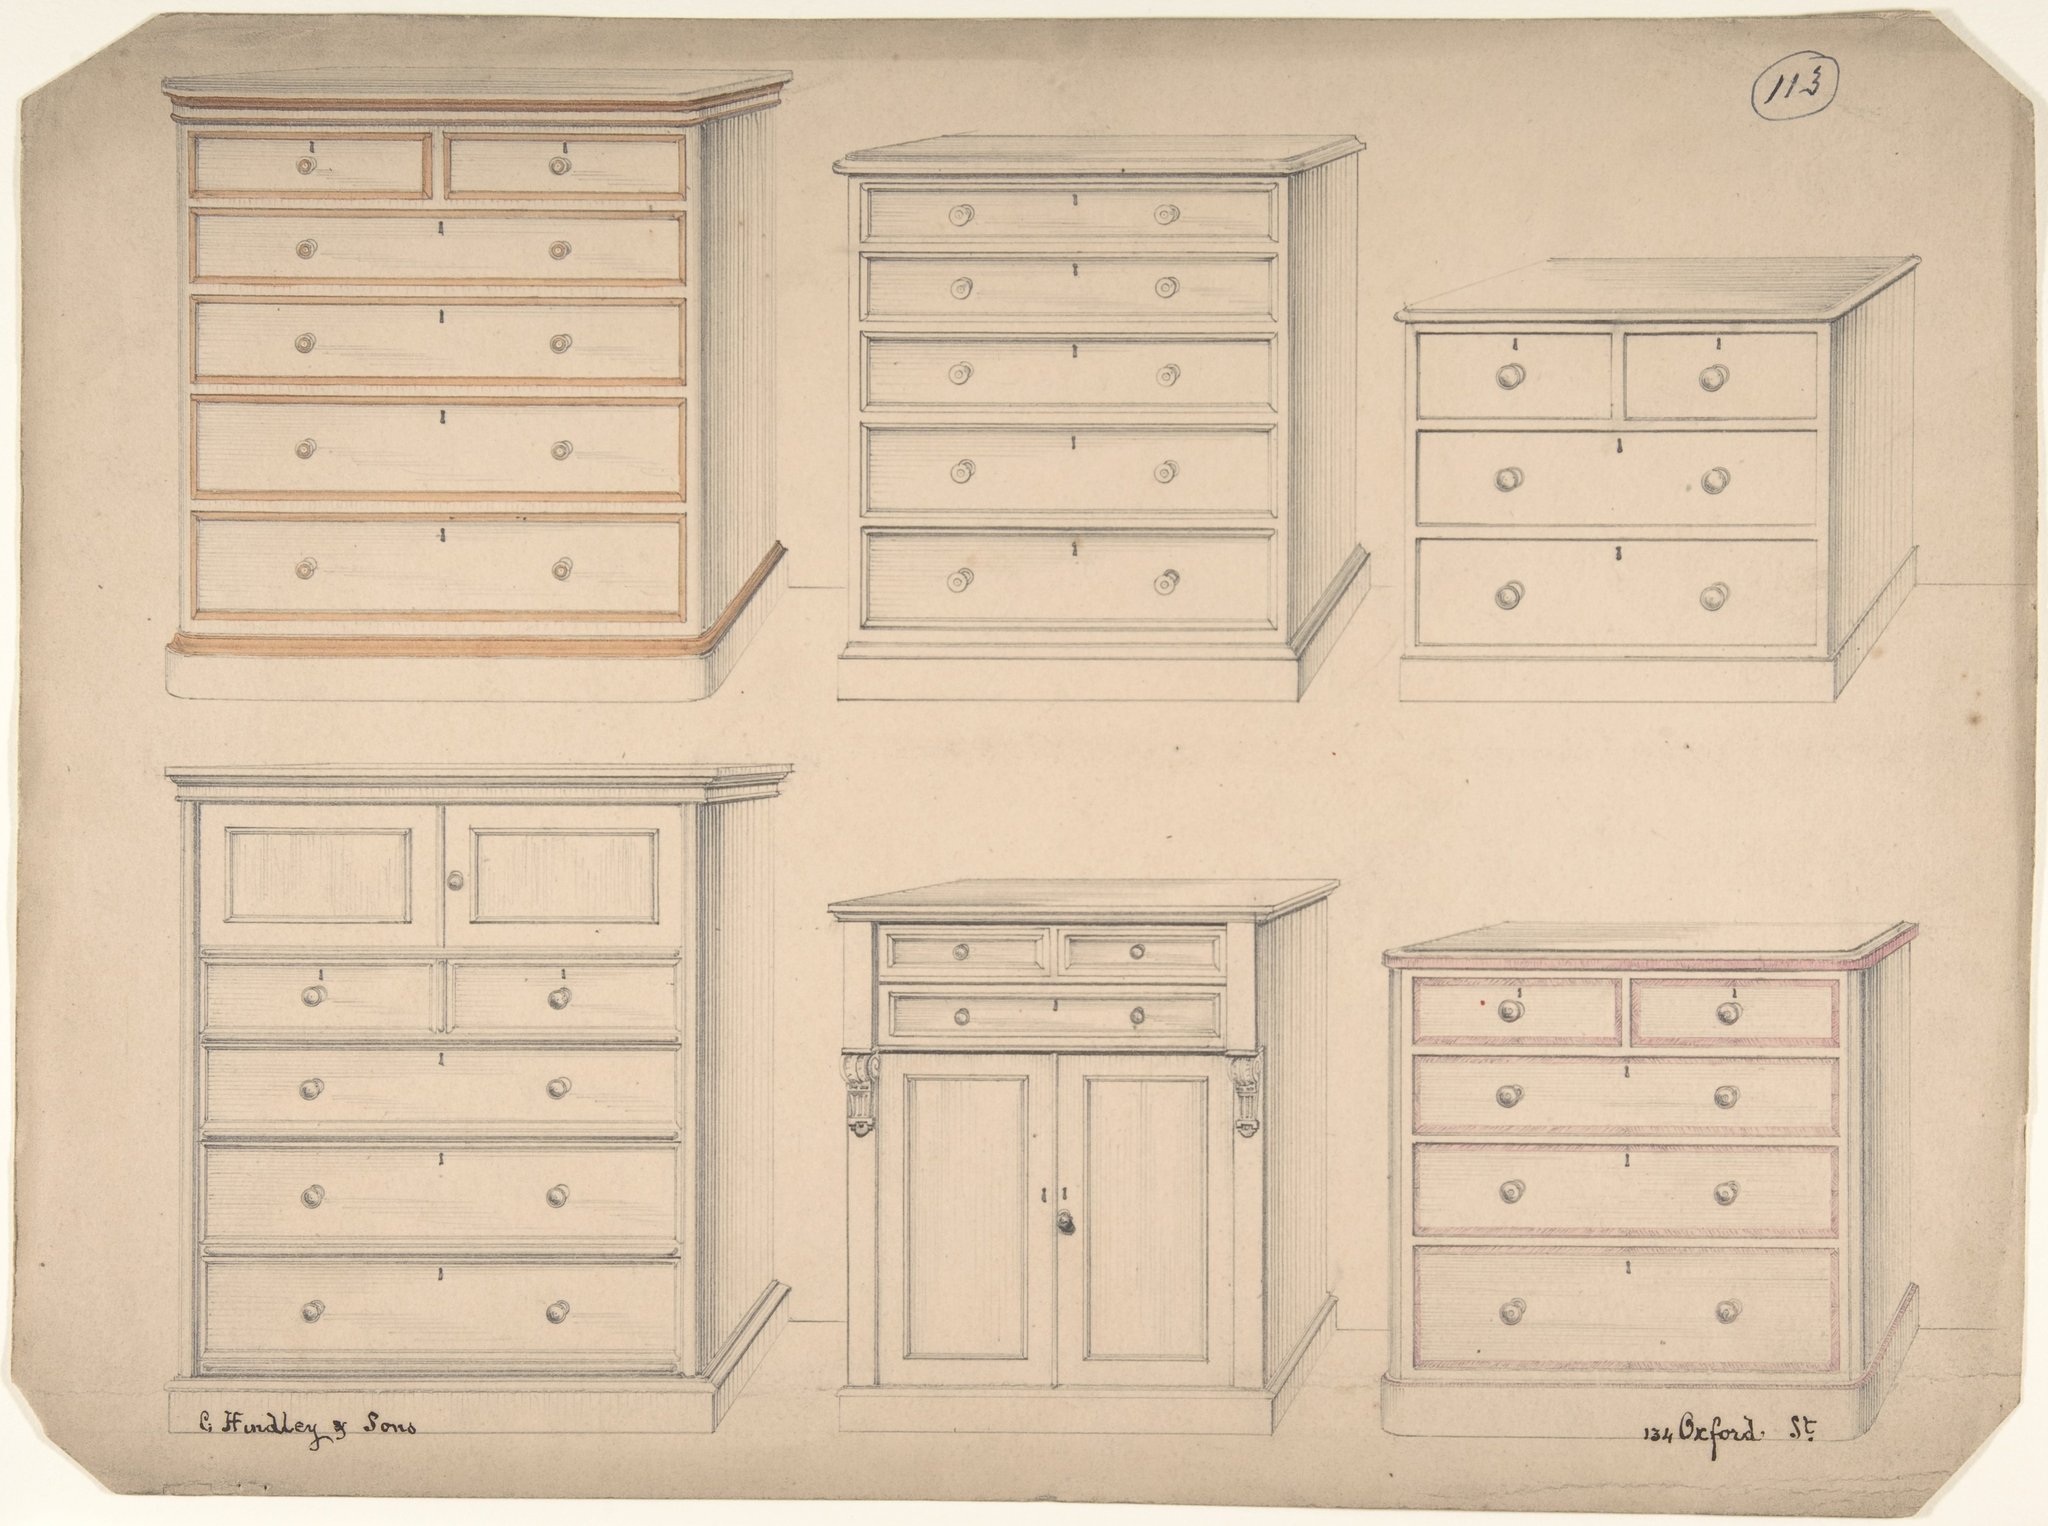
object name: drawing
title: Designs for Chests of Drawers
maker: charles hindley and sons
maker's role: artist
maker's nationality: british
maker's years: 1841-1917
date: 1841-1884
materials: graphite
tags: chests